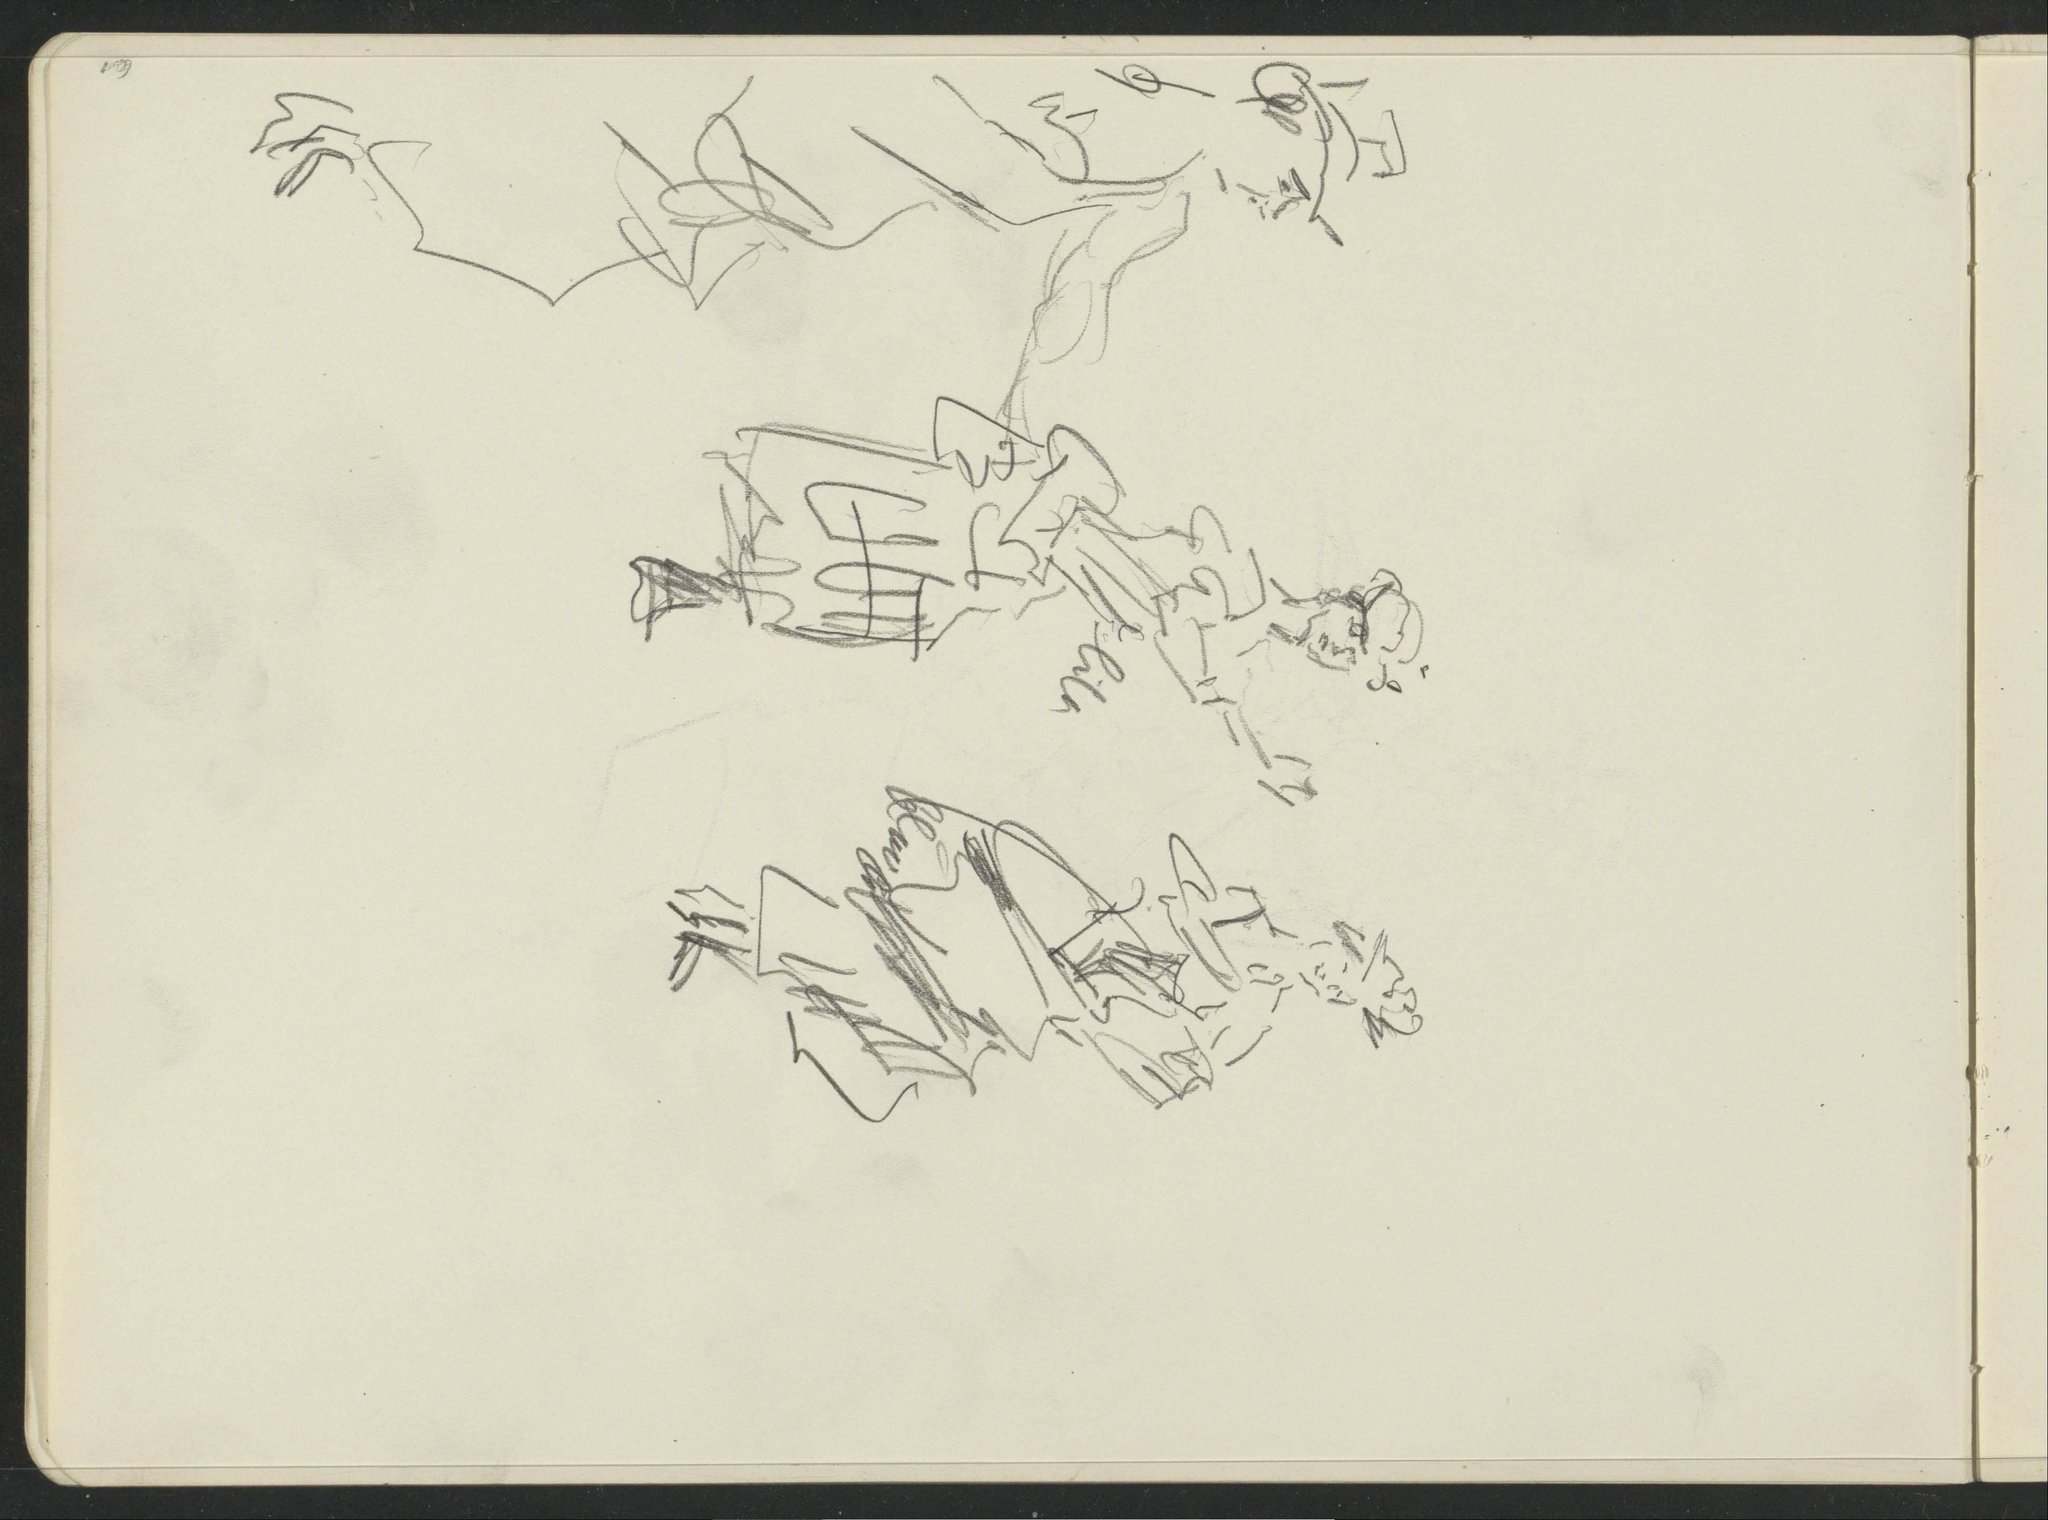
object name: sketchbook leaf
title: Studieblad met vrouwen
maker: isaac israels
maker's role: draughtsman, painter, print maker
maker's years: 1865-1934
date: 1915-1934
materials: paper, pencil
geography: the hague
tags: adult woman (+ standing)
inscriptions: : ‘lila’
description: Ze dragen hoeden. Blad 10 verso uit schetsboek XVIII met 35 bladen.